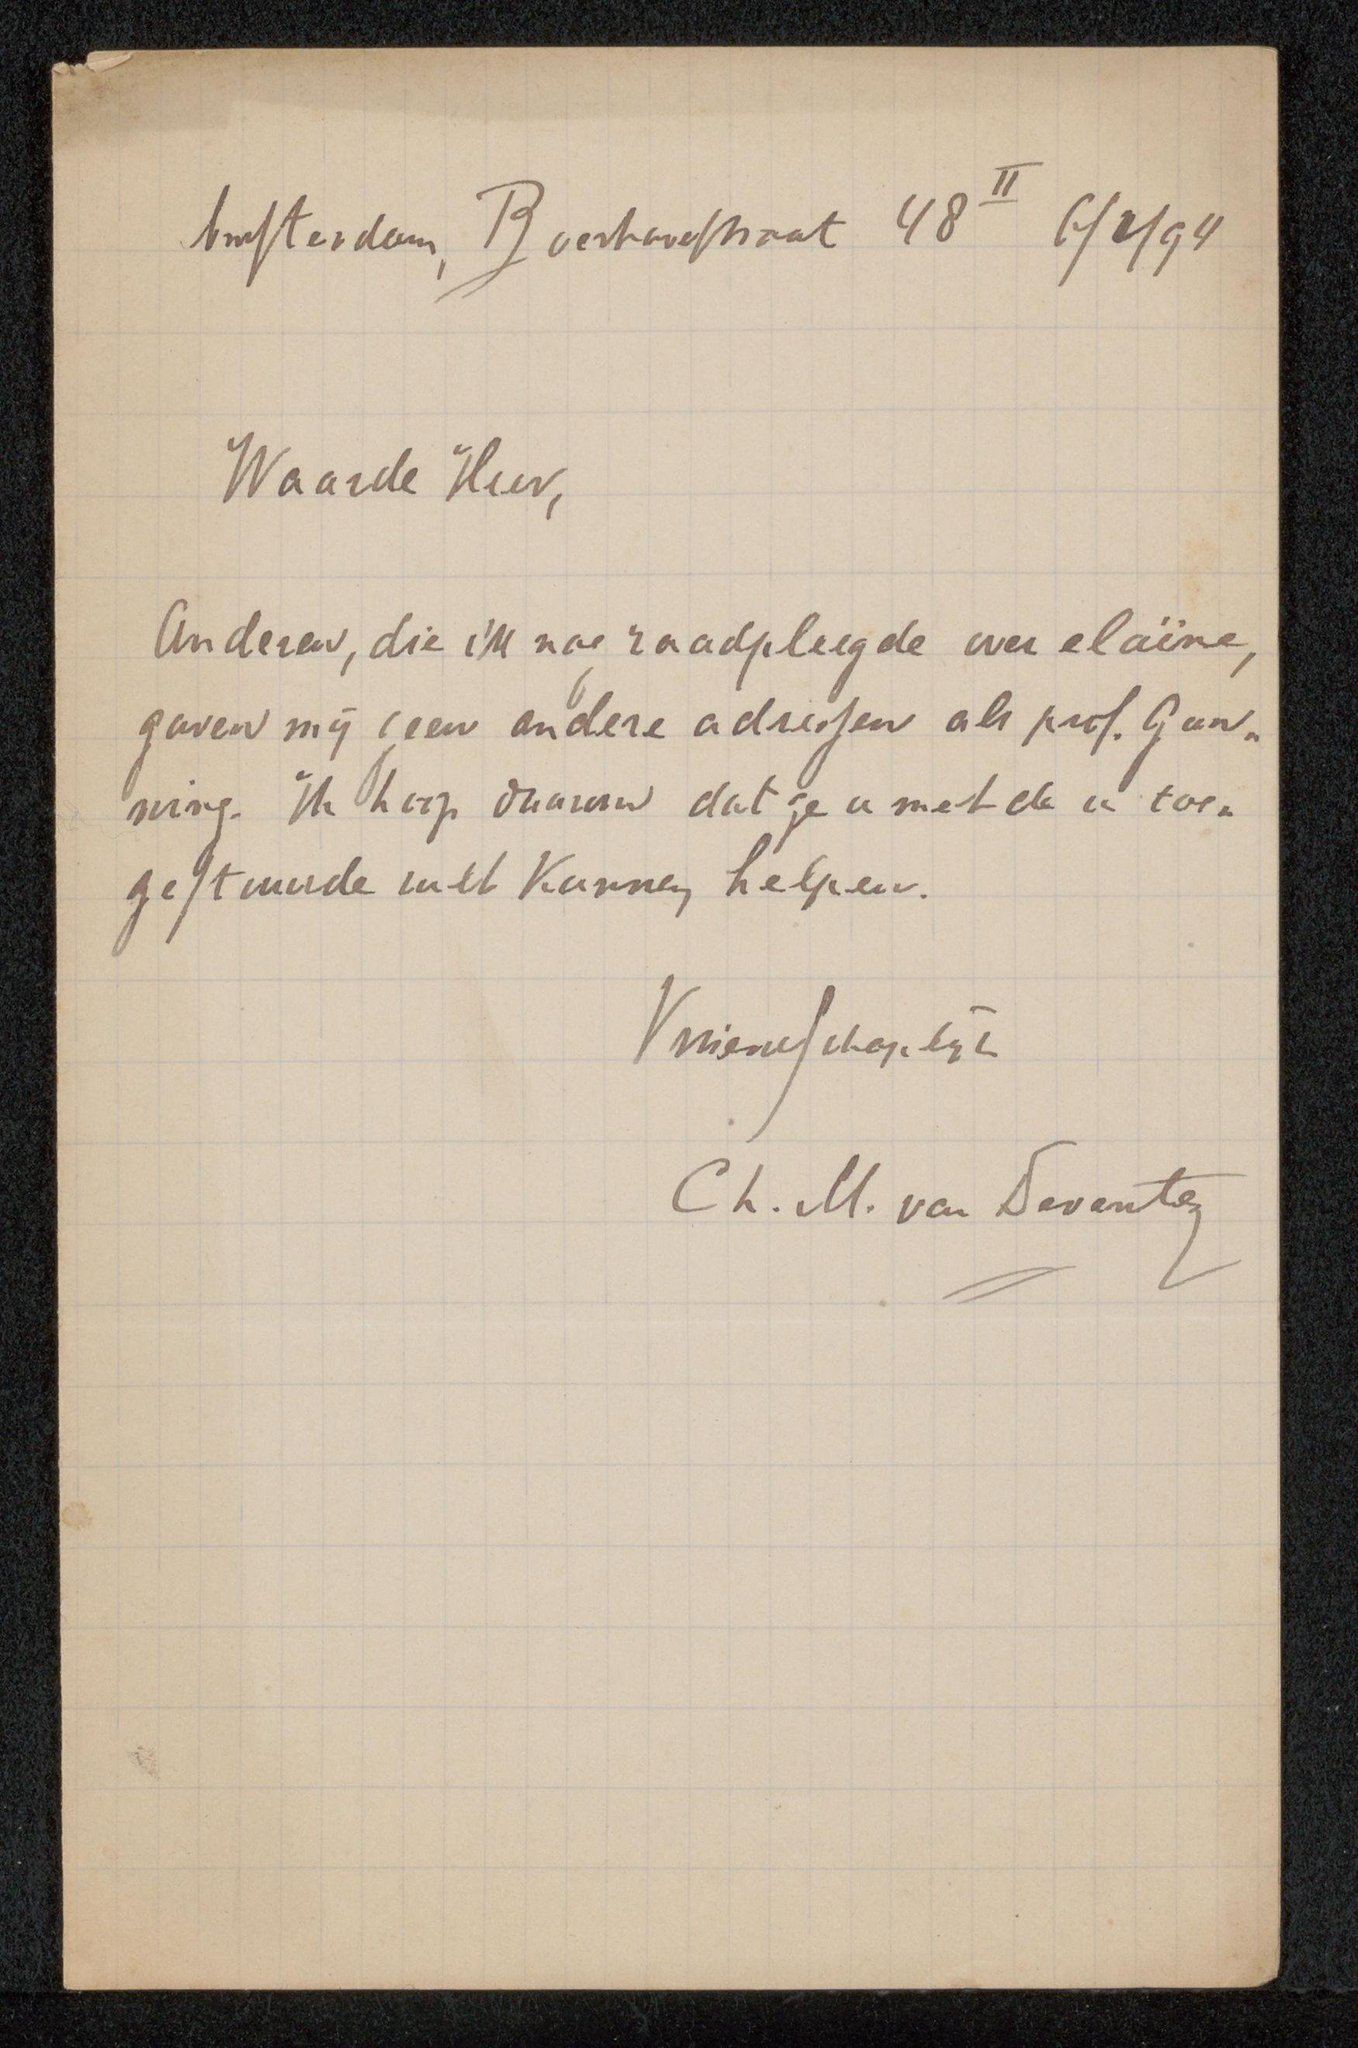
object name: letter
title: Brief aan Philip Zilcken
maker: chap van deventer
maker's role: kunstcriticus, scheikundige, schrijver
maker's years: 1860-1931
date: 1894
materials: ink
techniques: pen, writing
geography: amsterdam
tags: amsterdam, the hague, painter, draughtsman, philip zilcken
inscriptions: collector's mark: ‘RPK’